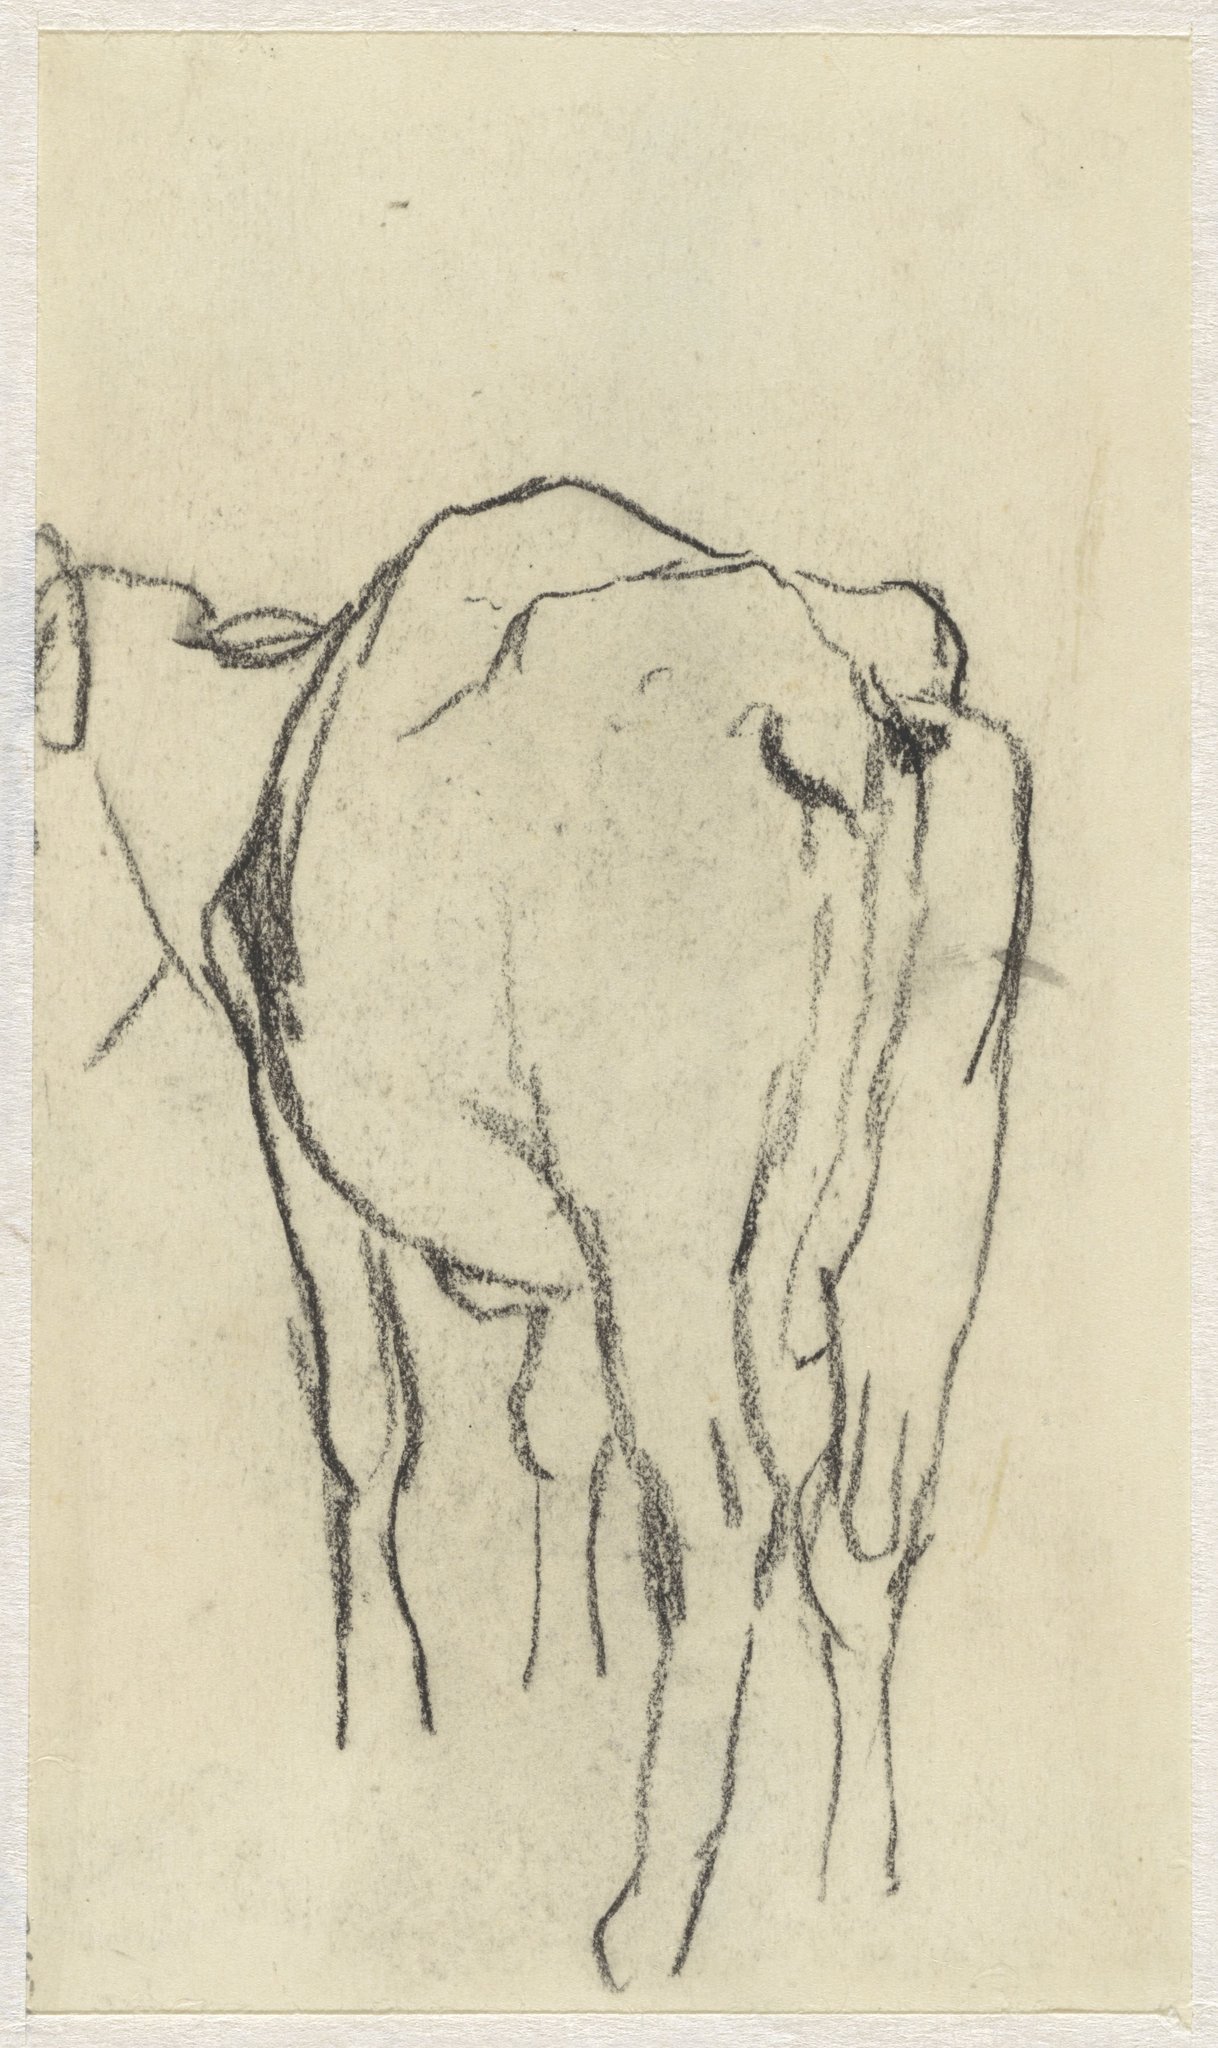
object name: drawing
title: Staande koe, van achteren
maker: anton mauve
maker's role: draughtsman, painter, print maker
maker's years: 1838-1888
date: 1848-1888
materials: chalk, paper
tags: cow